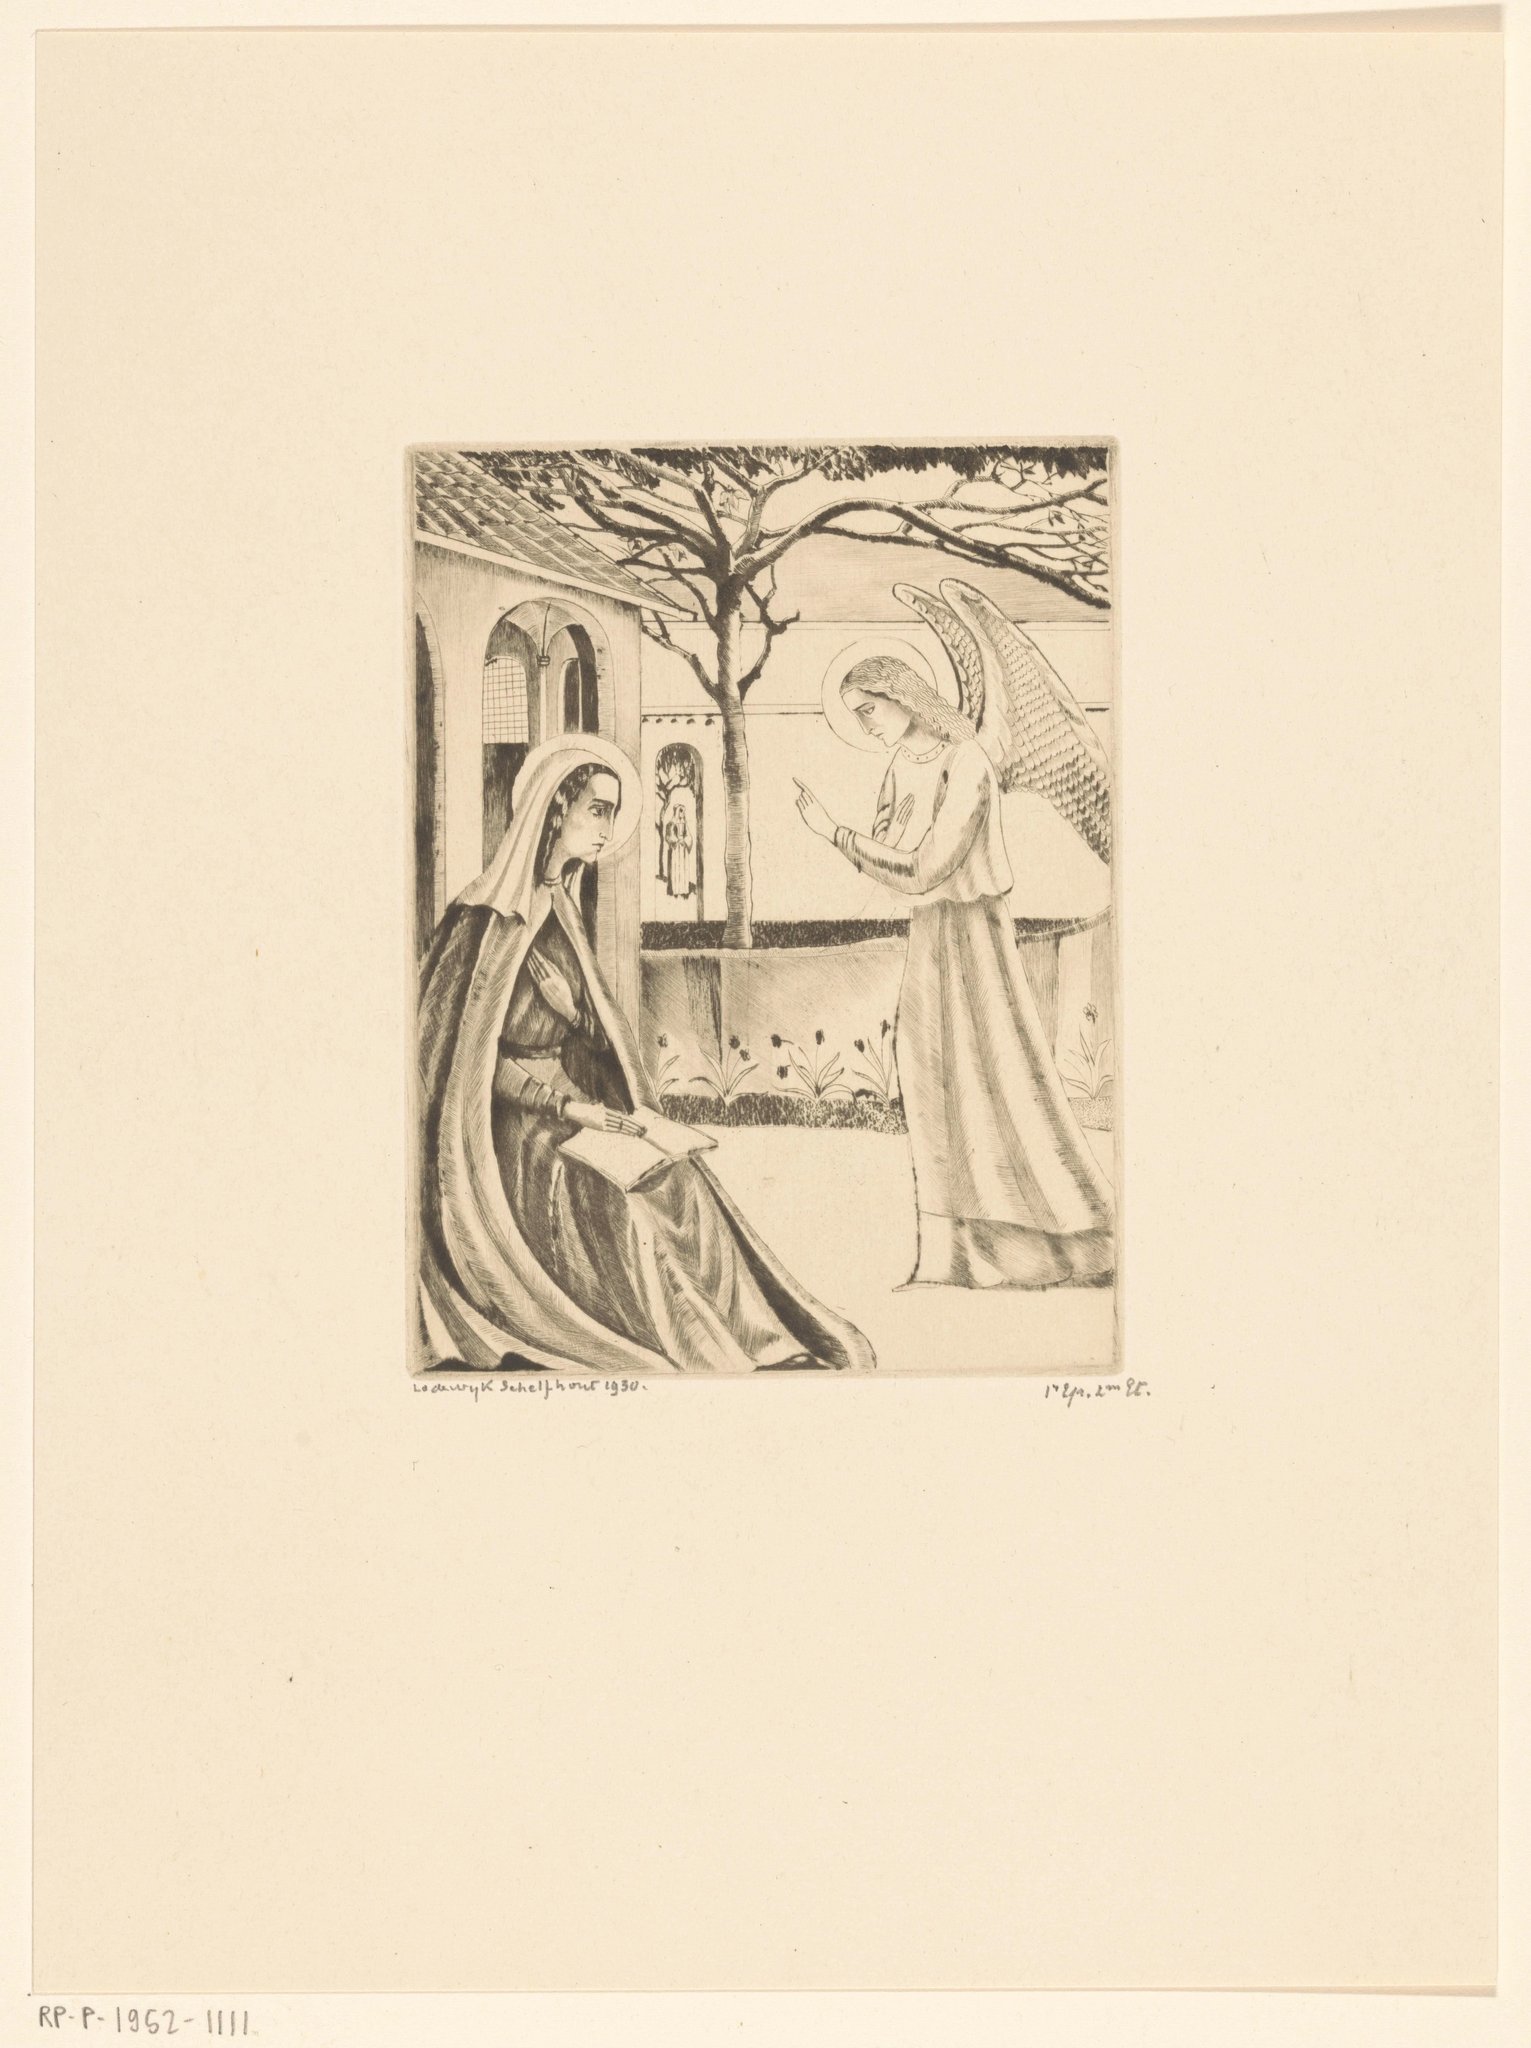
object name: print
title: Annunciatie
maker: lodewijk schelfhout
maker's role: draughtsman, print maker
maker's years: 1881-1943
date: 1930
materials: paper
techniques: drypoint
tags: the annunciation: mary, usually reading, is visited by the angel (sometimes a woman overhears the conversation)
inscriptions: collector's mark: Lugt 2228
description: Links Maria en rechts de engel Gabriël, die aan haar verkondigt dat ze zwanger zal worden en een zoon zal baren. Ze bevinden zich in een ommuurde tuin met bloeiende planten. Maria houdt met haar hand een opengeslagen boek vast. Bij deze tweede staat van de prent is er een poort in de tuinmuur toegevoegd met daarachter een vrouw die getuige is van de annunciatie.